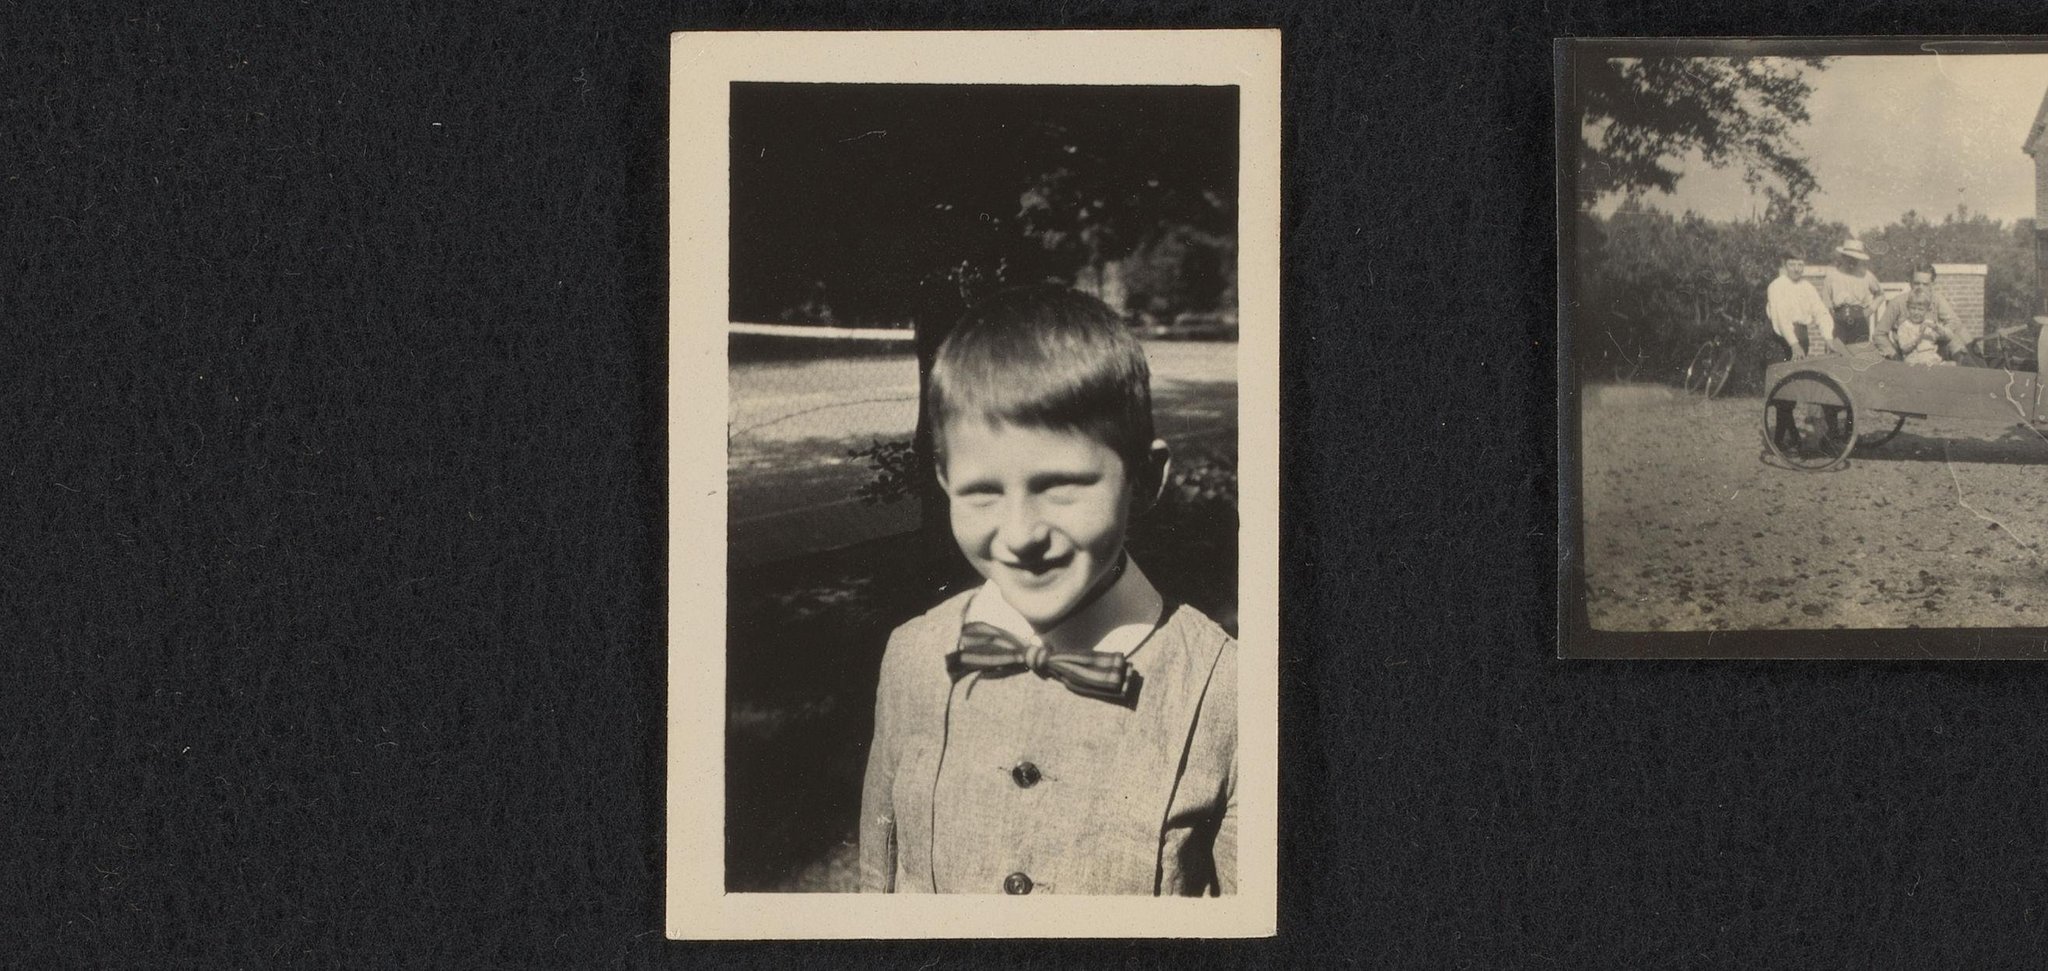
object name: photograph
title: Onbekend kind van de familie van den Berg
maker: hendrik herman van den berg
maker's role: amateurfotograaf, jurist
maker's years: 1875-1944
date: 1920-1921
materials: paper, cardboard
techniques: gelatin silver print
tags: anonymous historical person portrayed